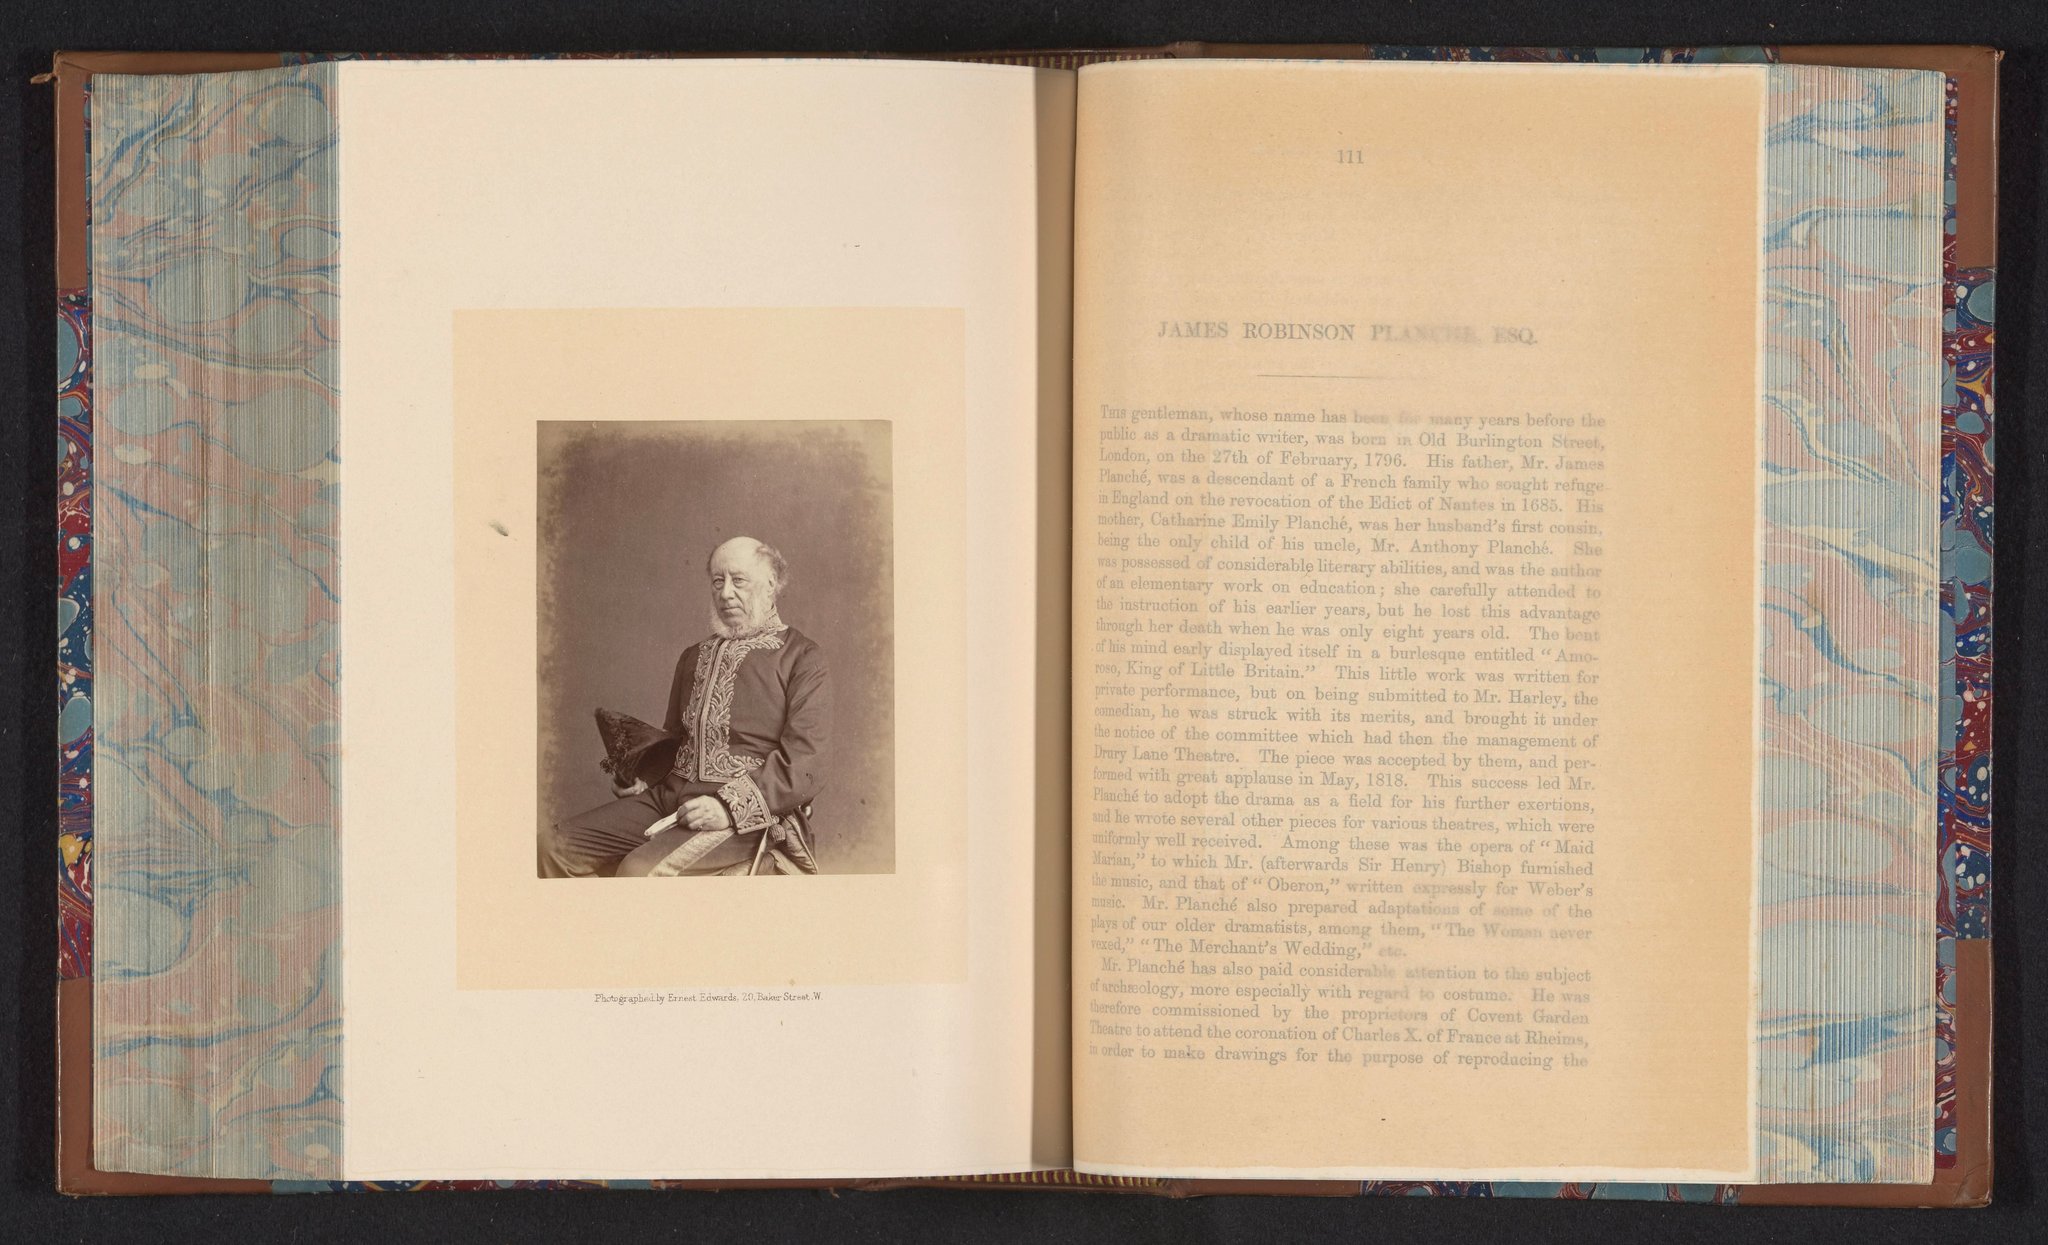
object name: page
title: Portret van James Planché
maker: ernest edwards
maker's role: fotograaf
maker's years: 1837-1903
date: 1856-1866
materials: photographic support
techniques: albumen print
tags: writer, poet, author, (military) uniforms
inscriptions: name: ‘Photographed by Ernest Edwards, 20, Baker Street. W.’